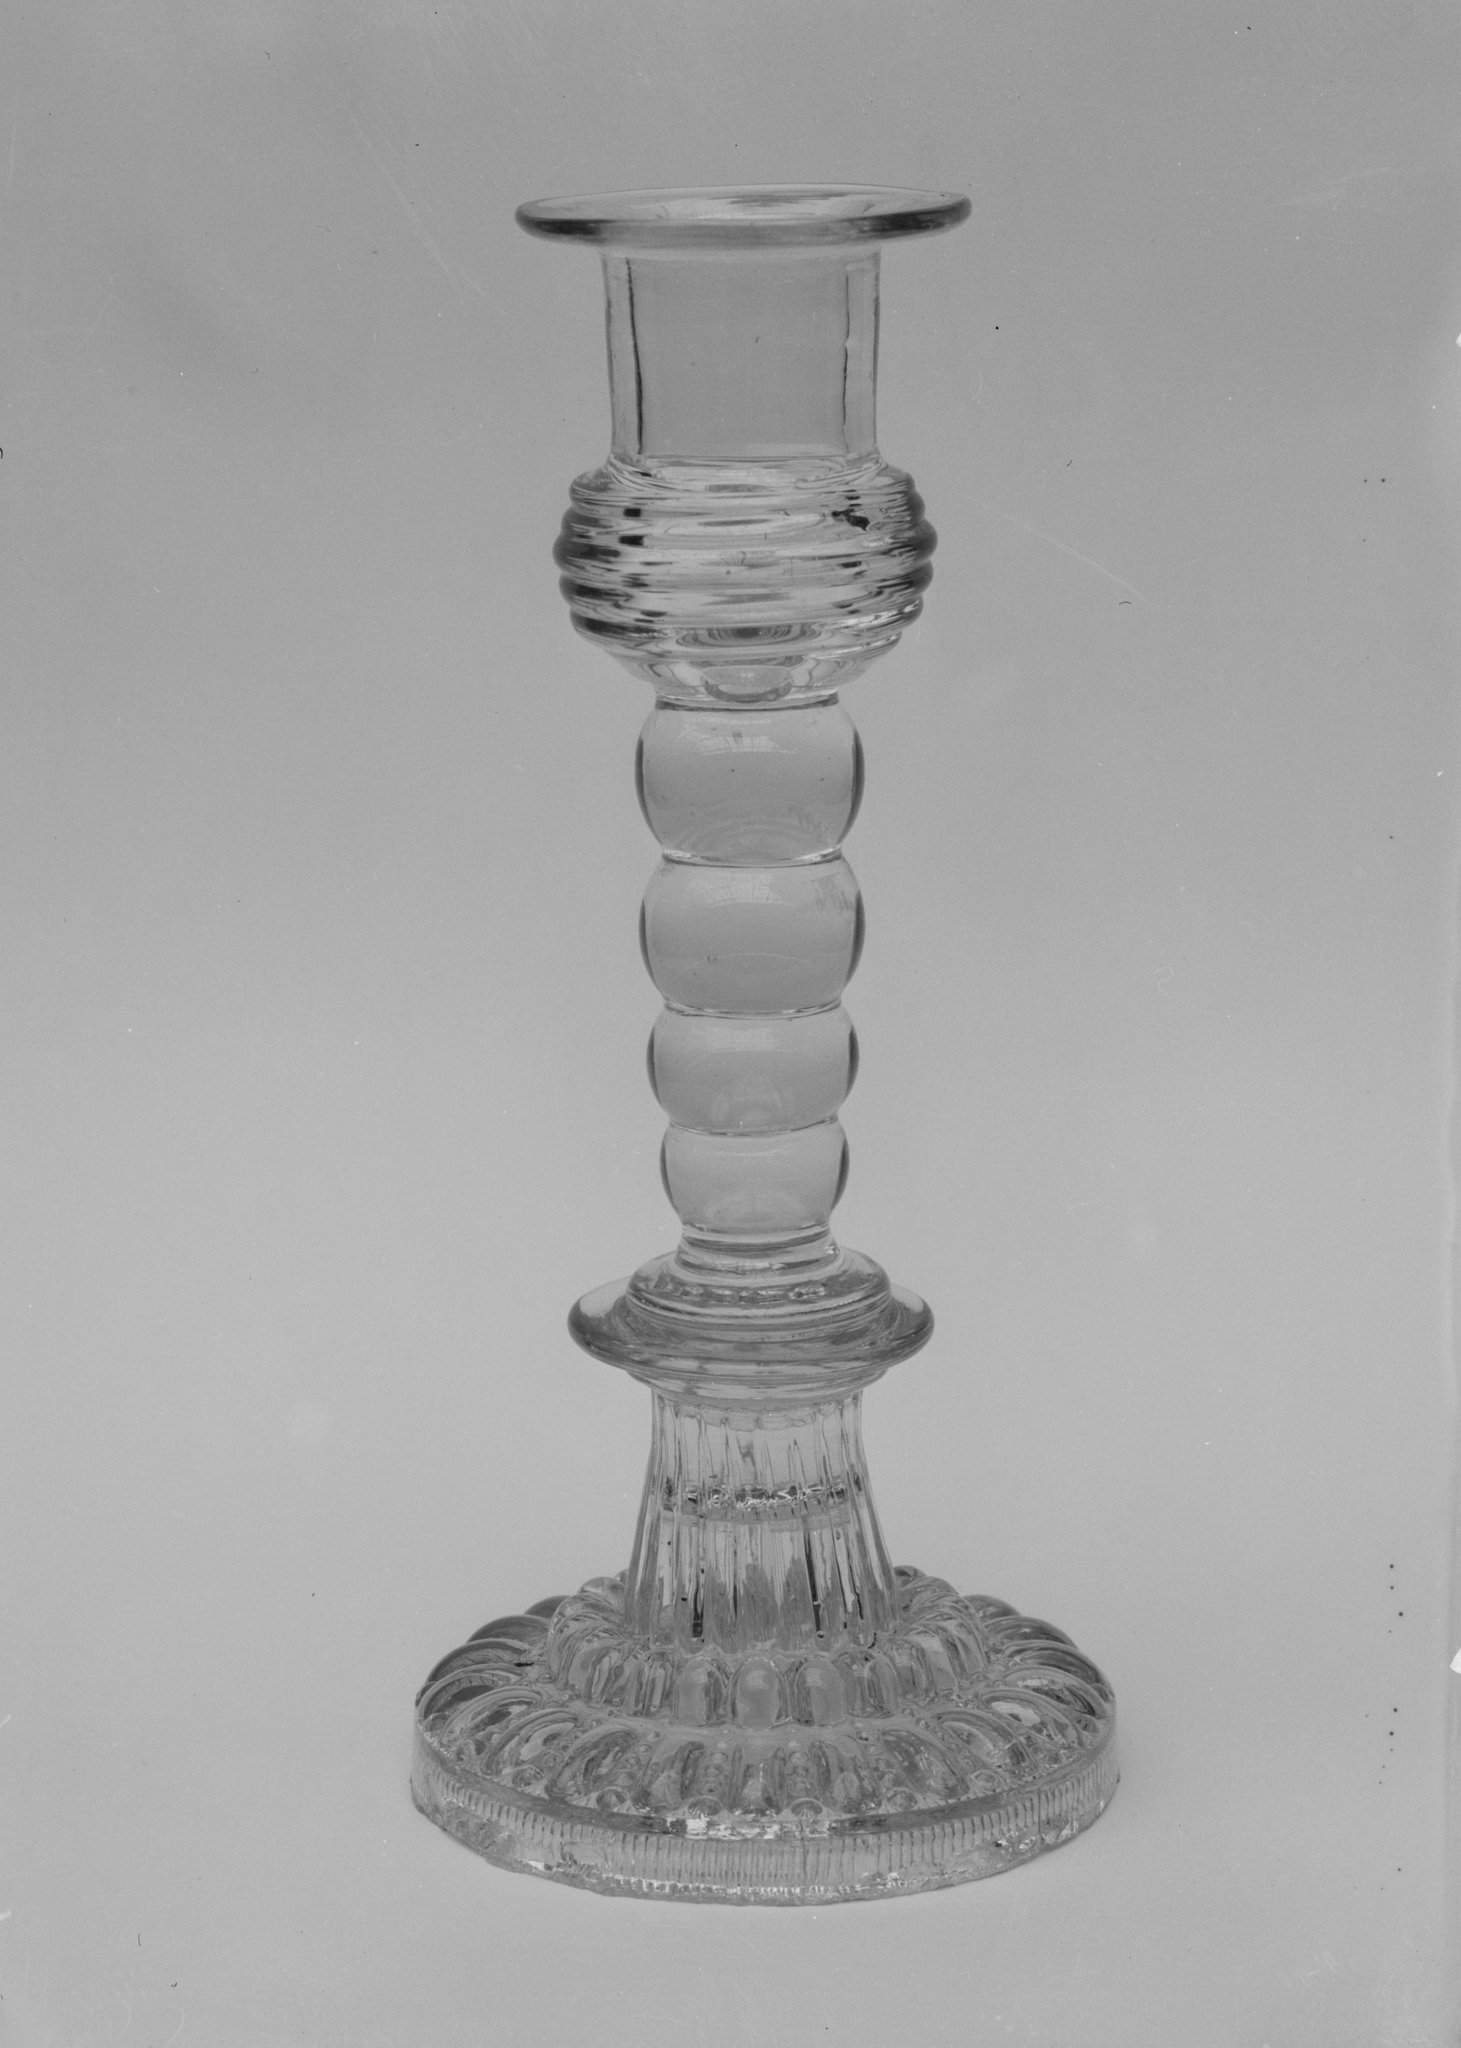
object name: candlestick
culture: american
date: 1825-1850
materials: glass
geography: united states